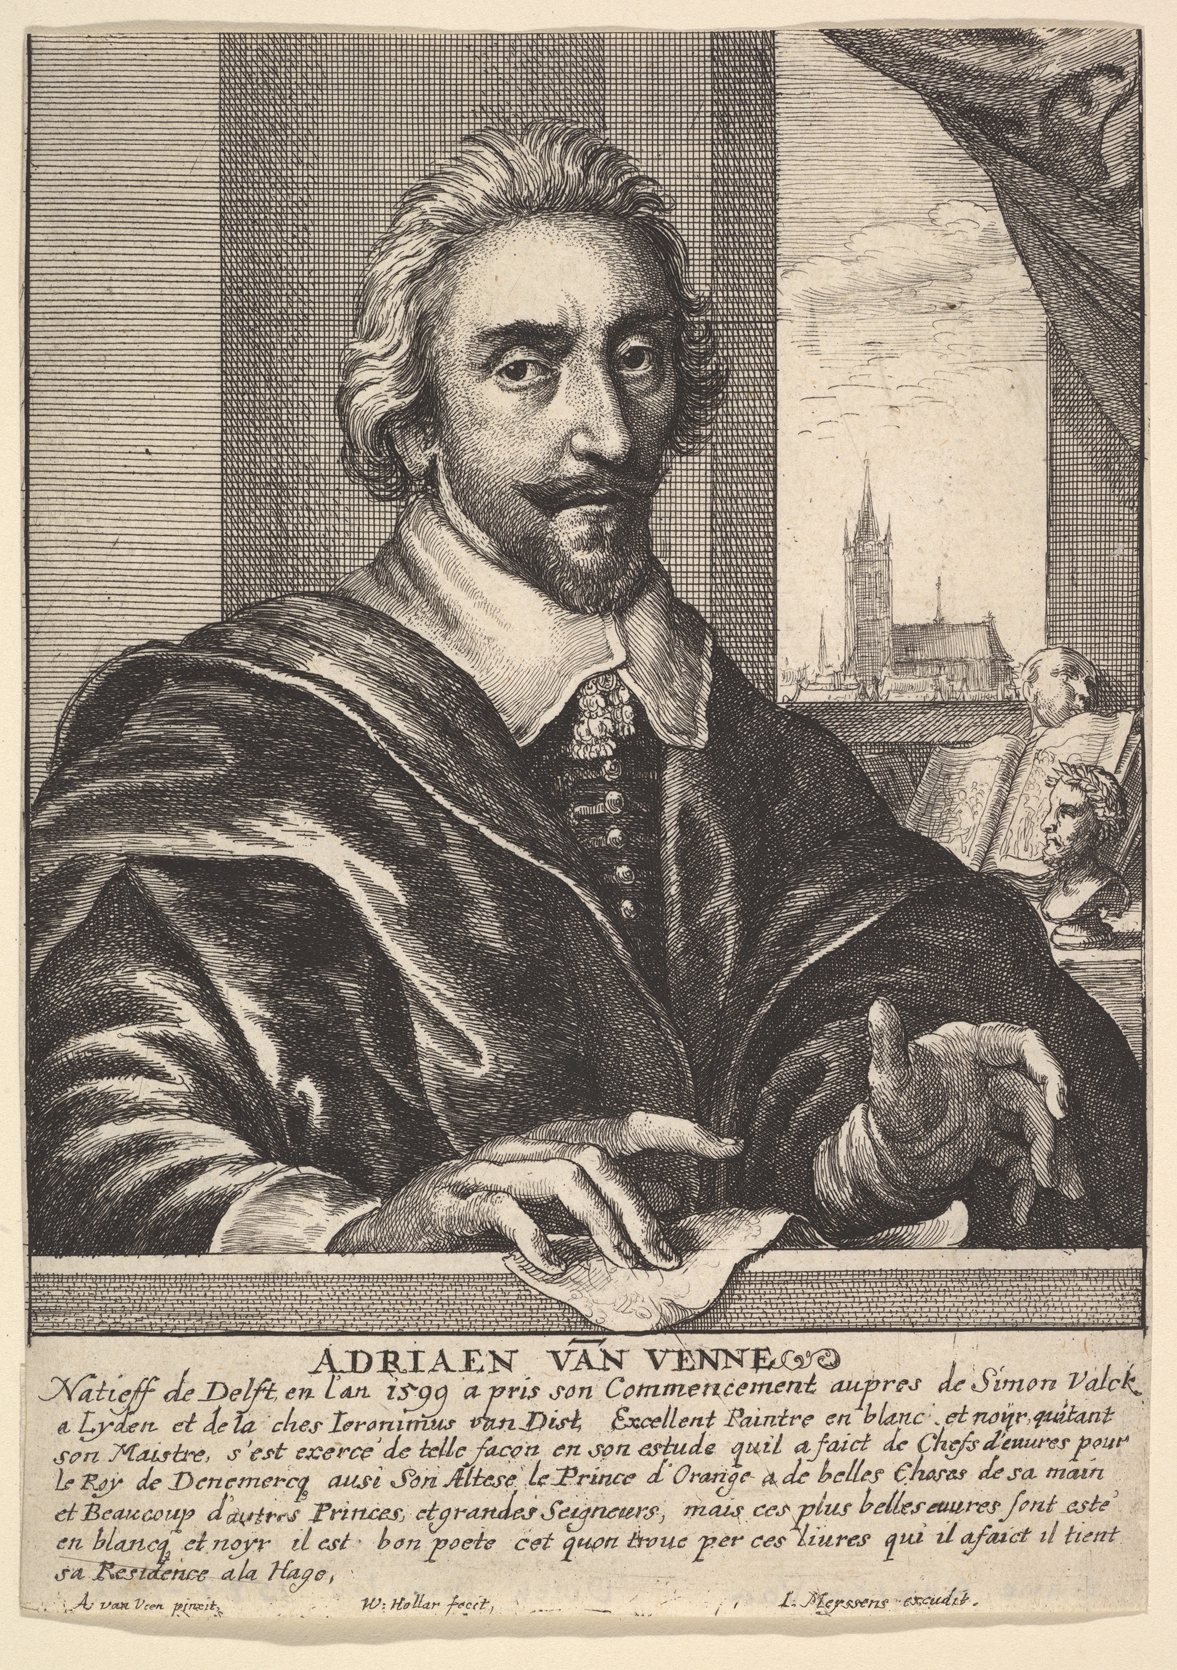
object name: print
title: Adriaen van de Venne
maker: wenceslaus hollar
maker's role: artist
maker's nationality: bohemian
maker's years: 1607-1677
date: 1649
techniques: etching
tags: men,portraits